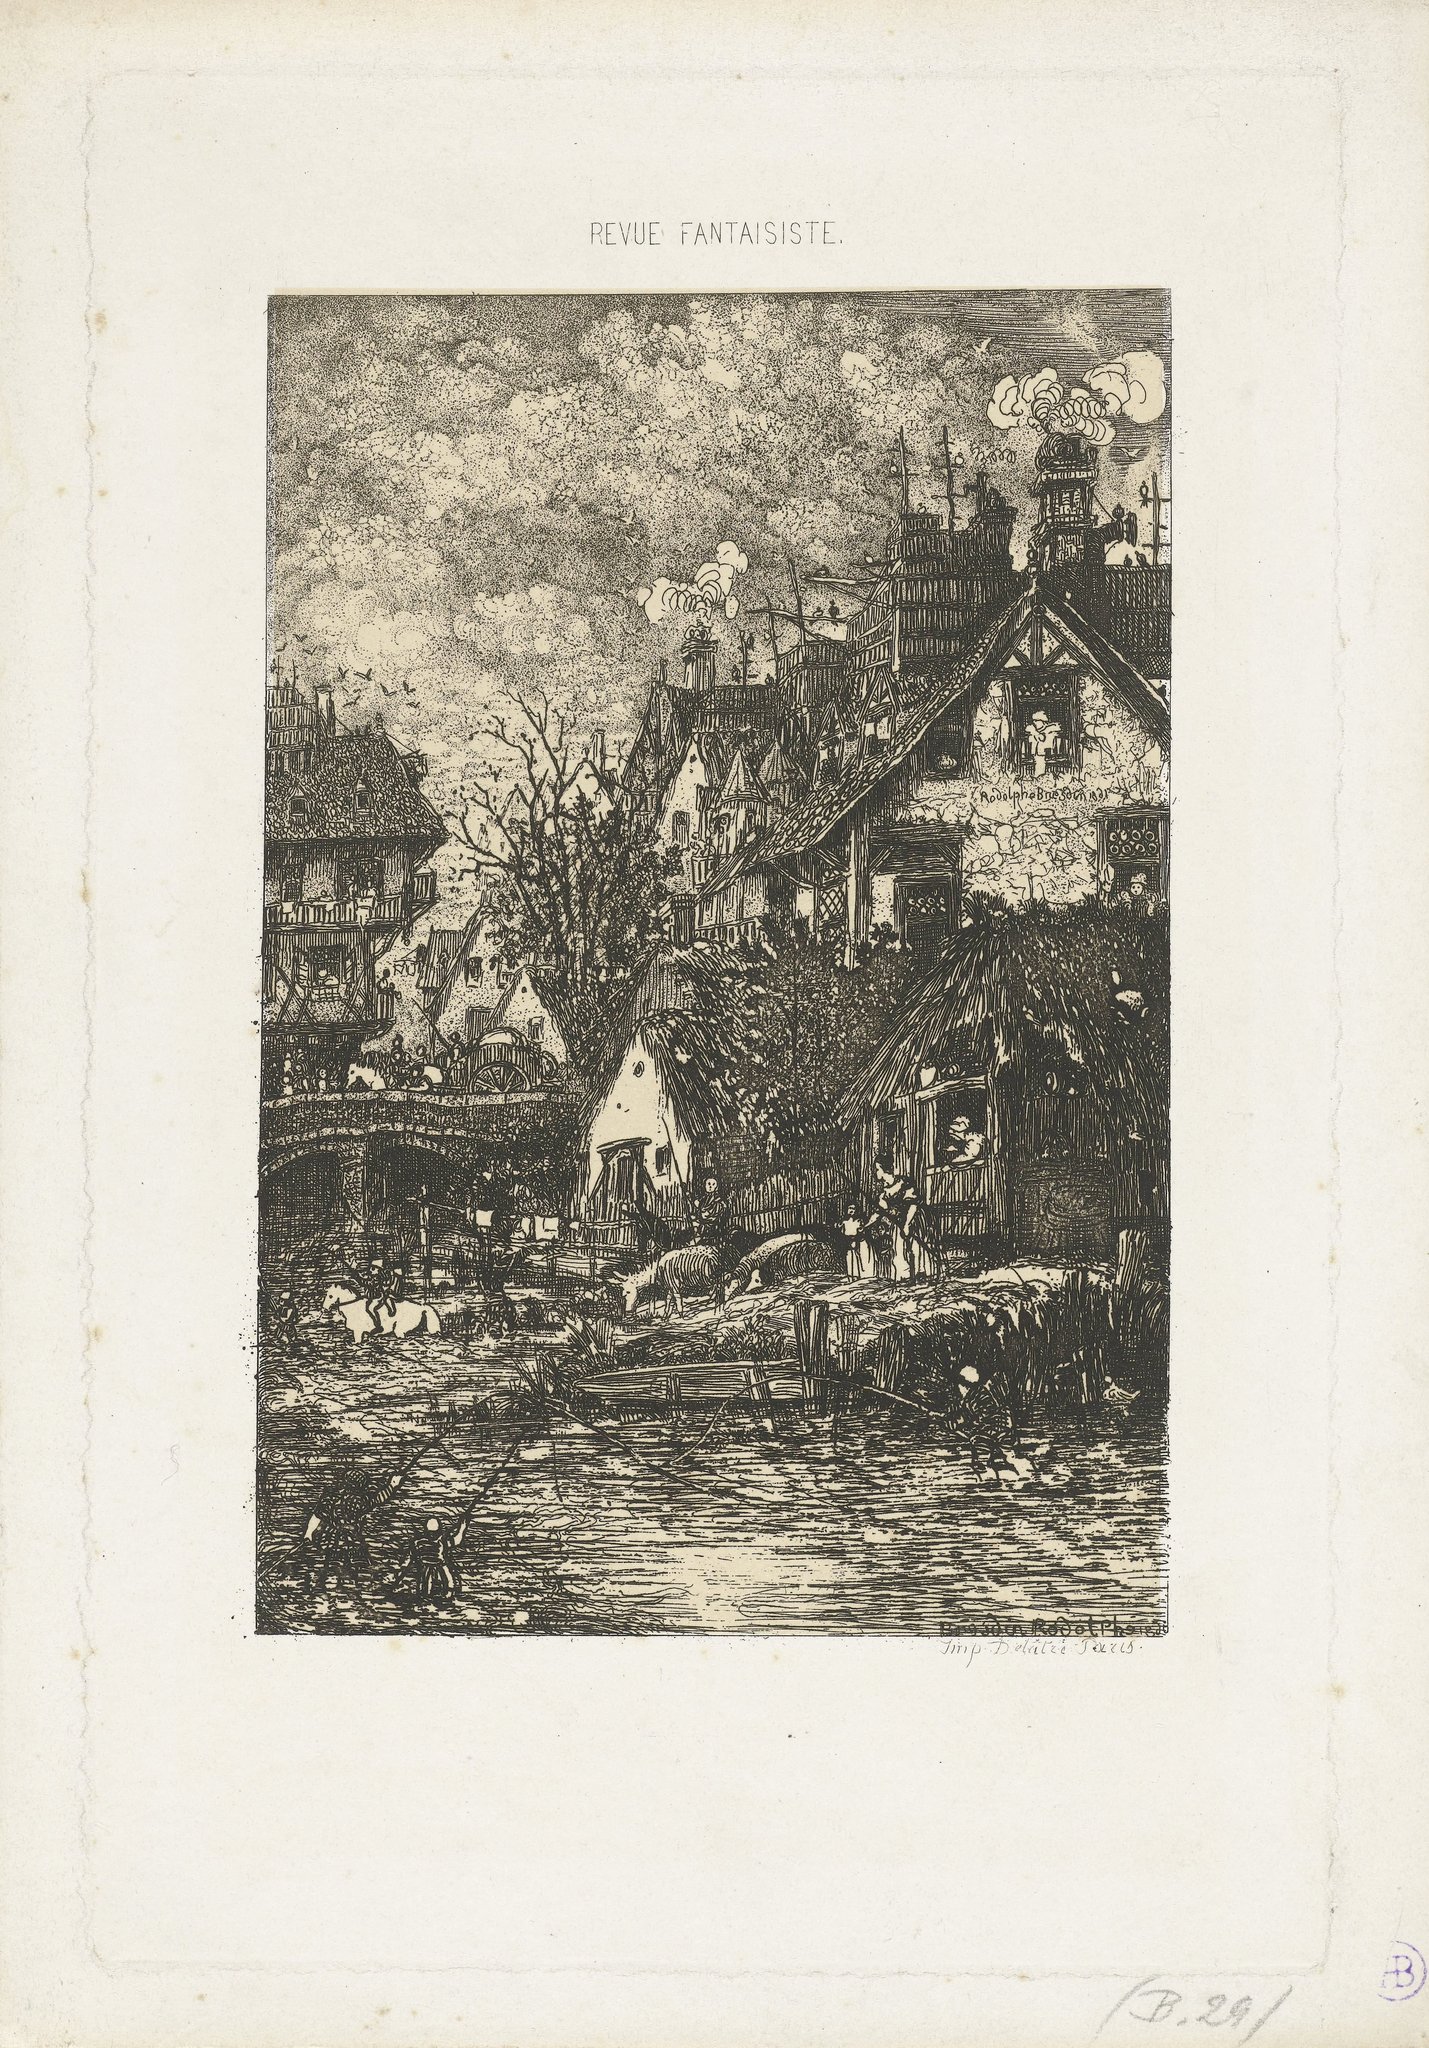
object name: print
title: Dorpsgezicht met een rivier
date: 1861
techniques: printmaking, etching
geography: paris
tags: village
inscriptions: collector's mark: Lugt 2228, collector's mark: Lugt 76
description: Dorpsgezicht met een rivier. Rechts op de oever staan huizen op een rij langs de rivier die met een bocht links onder een brug het dorp in loopt. Op de voorgrond staan vissers met hengels in het ondiepe water. Boven de prent staat de titel van het literaire tijdschrift Revue Fantaisiste.